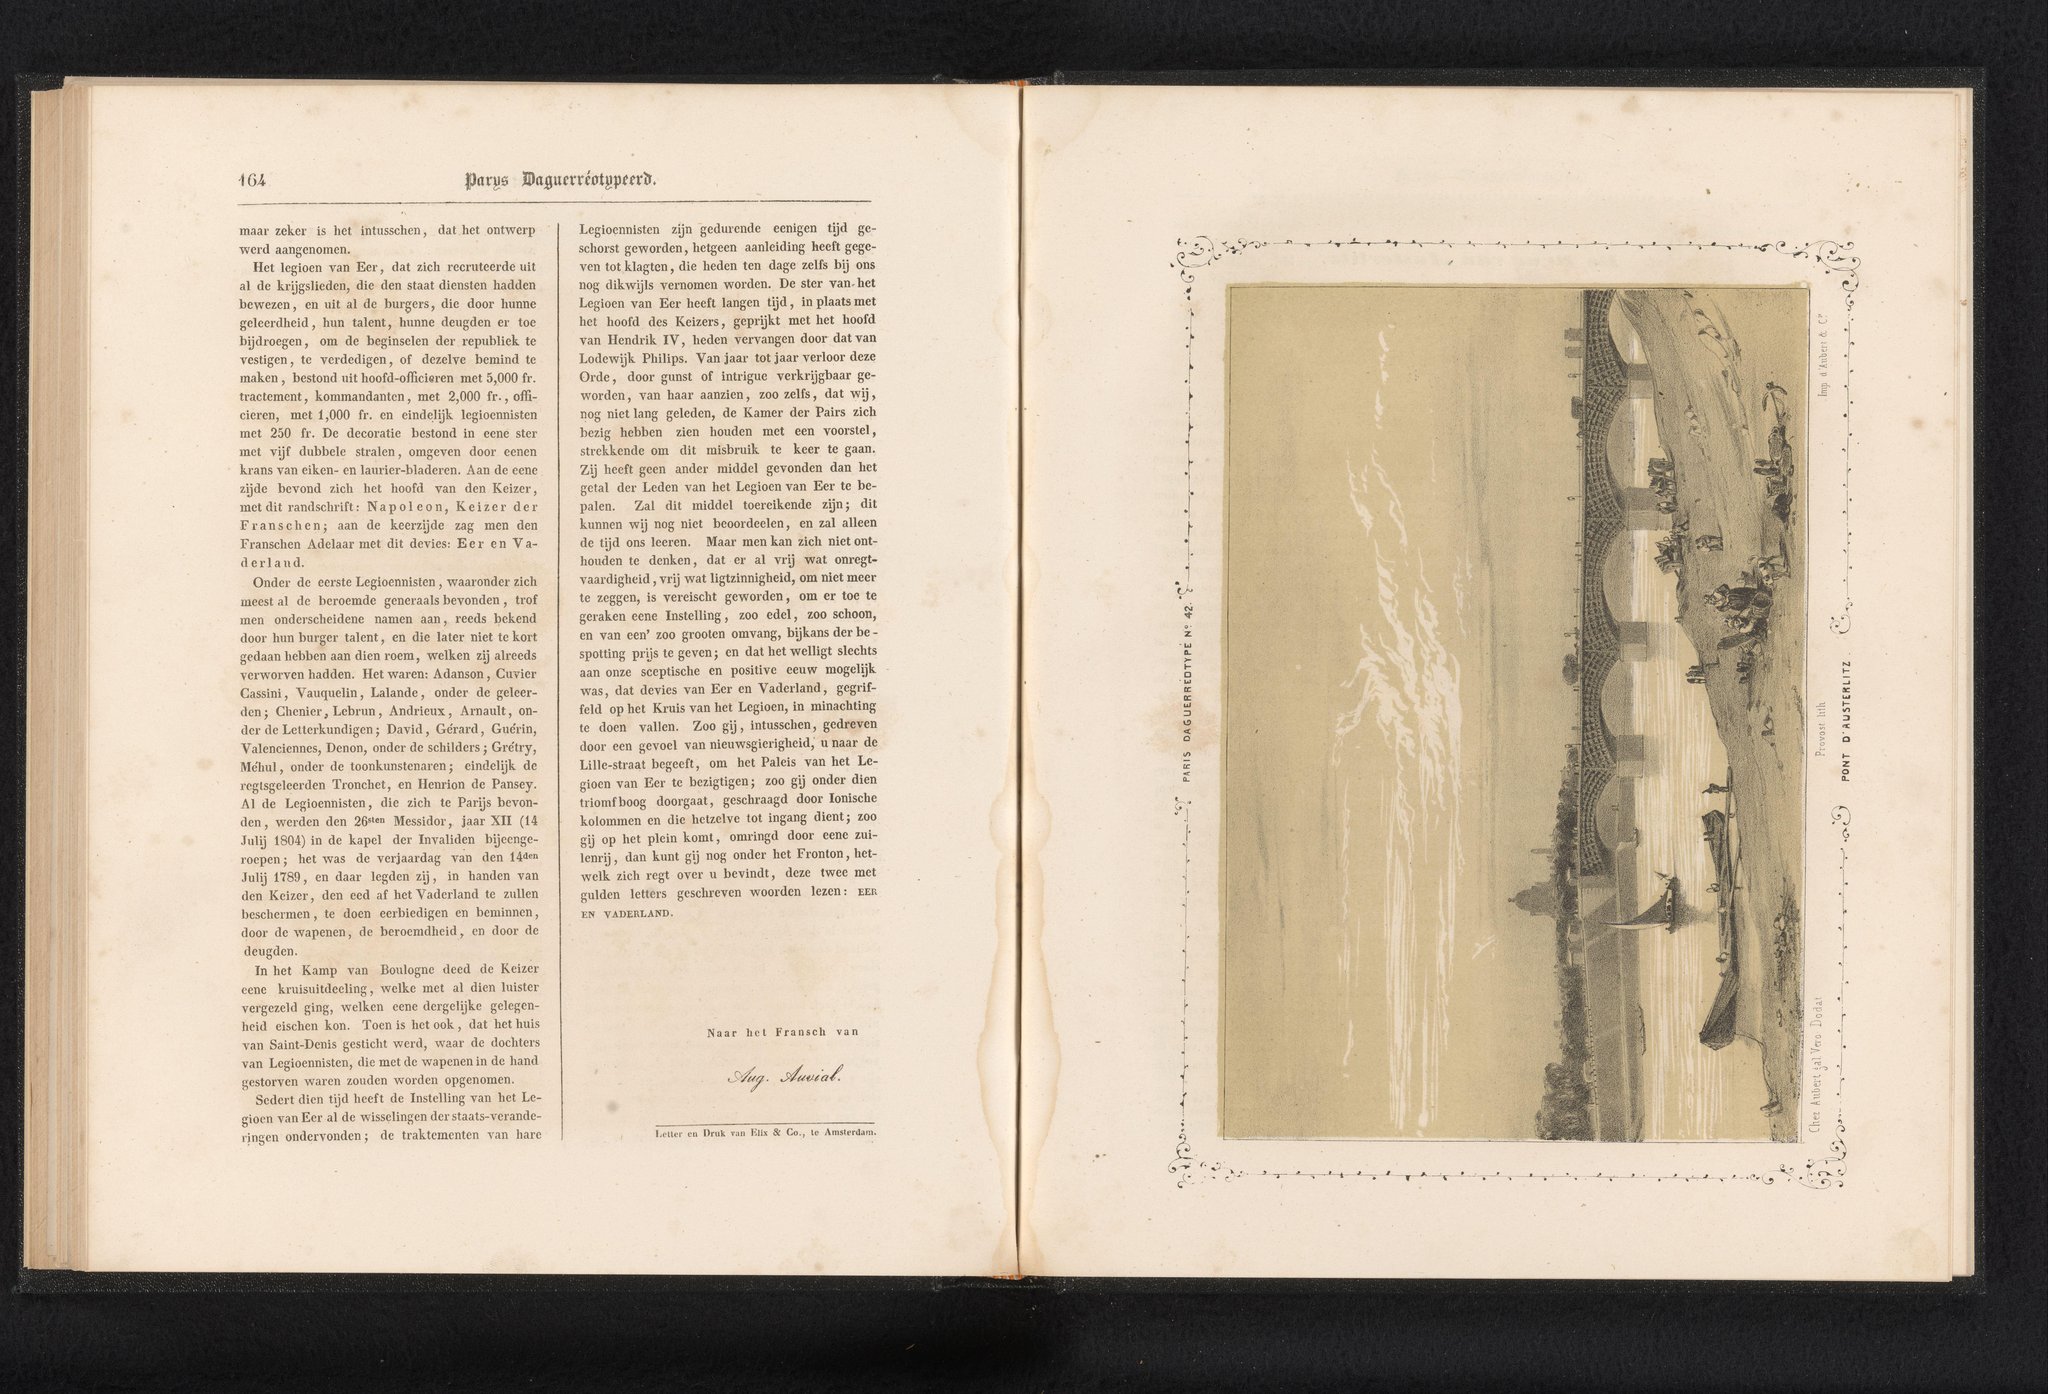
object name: page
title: Pont d'Austerlitz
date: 1839-1840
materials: paper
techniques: tone lithography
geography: paris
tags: bridge in city across river, canal, etc.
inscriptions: inscription: ‘PARIS DAGUERRÉOTYPÉ No. 42.’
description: Prent op honderdzevenenzestigste ongenummerde pagina.